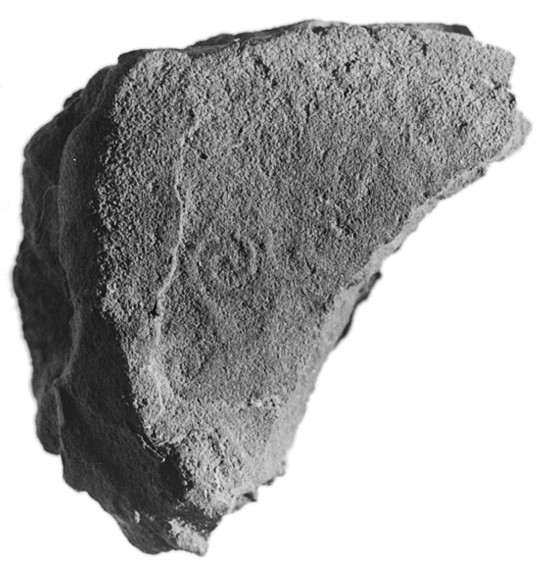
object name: sealing, administrative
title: Administrative Seal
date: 1981-1640 BCE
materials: clay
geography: egypt